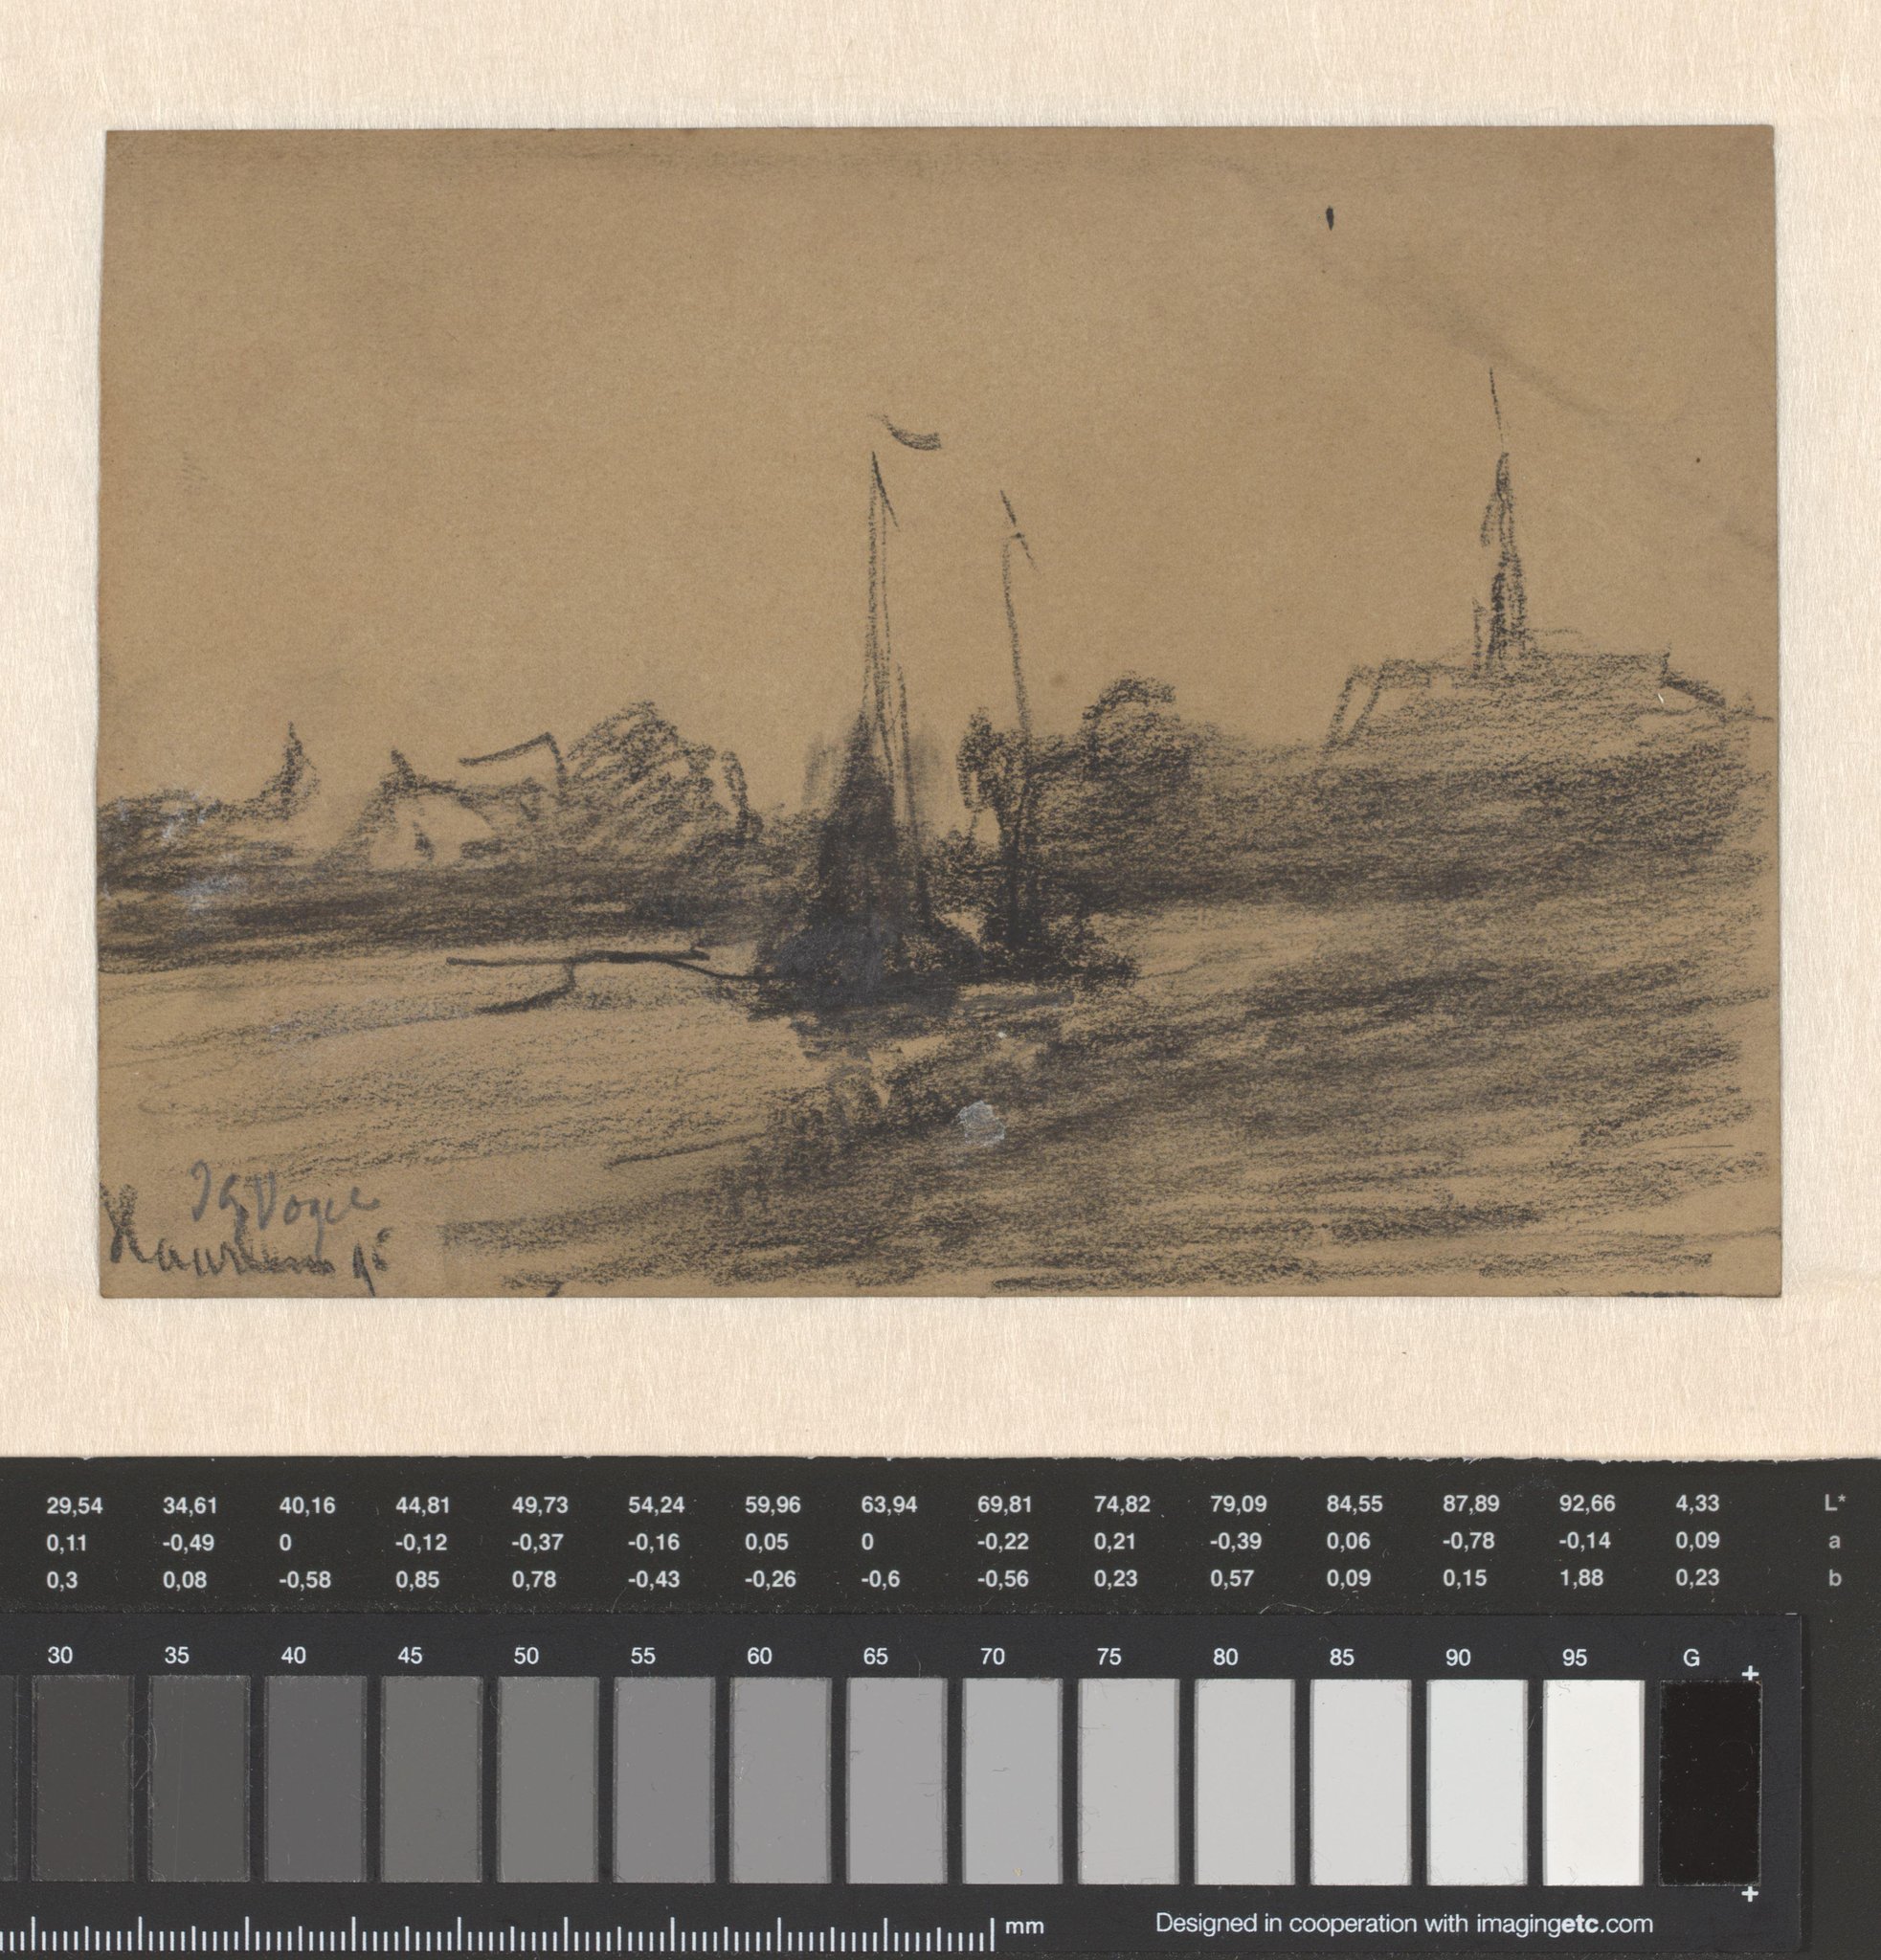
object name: drawing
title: Boten op het water bij Haarlem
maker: johannes gijsbert vogel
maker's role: draughtsman, painter, print maker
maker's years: 1828-1915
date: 1895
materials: chalk, paper, pencil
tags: sailing-ship, sailing-boat, landscapes with waters, waterscapes, seascapes (in the temperate zone), haarlem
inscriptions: date and inscription: ‘Haarlem 95’, collector's mark: Lugt 1181b